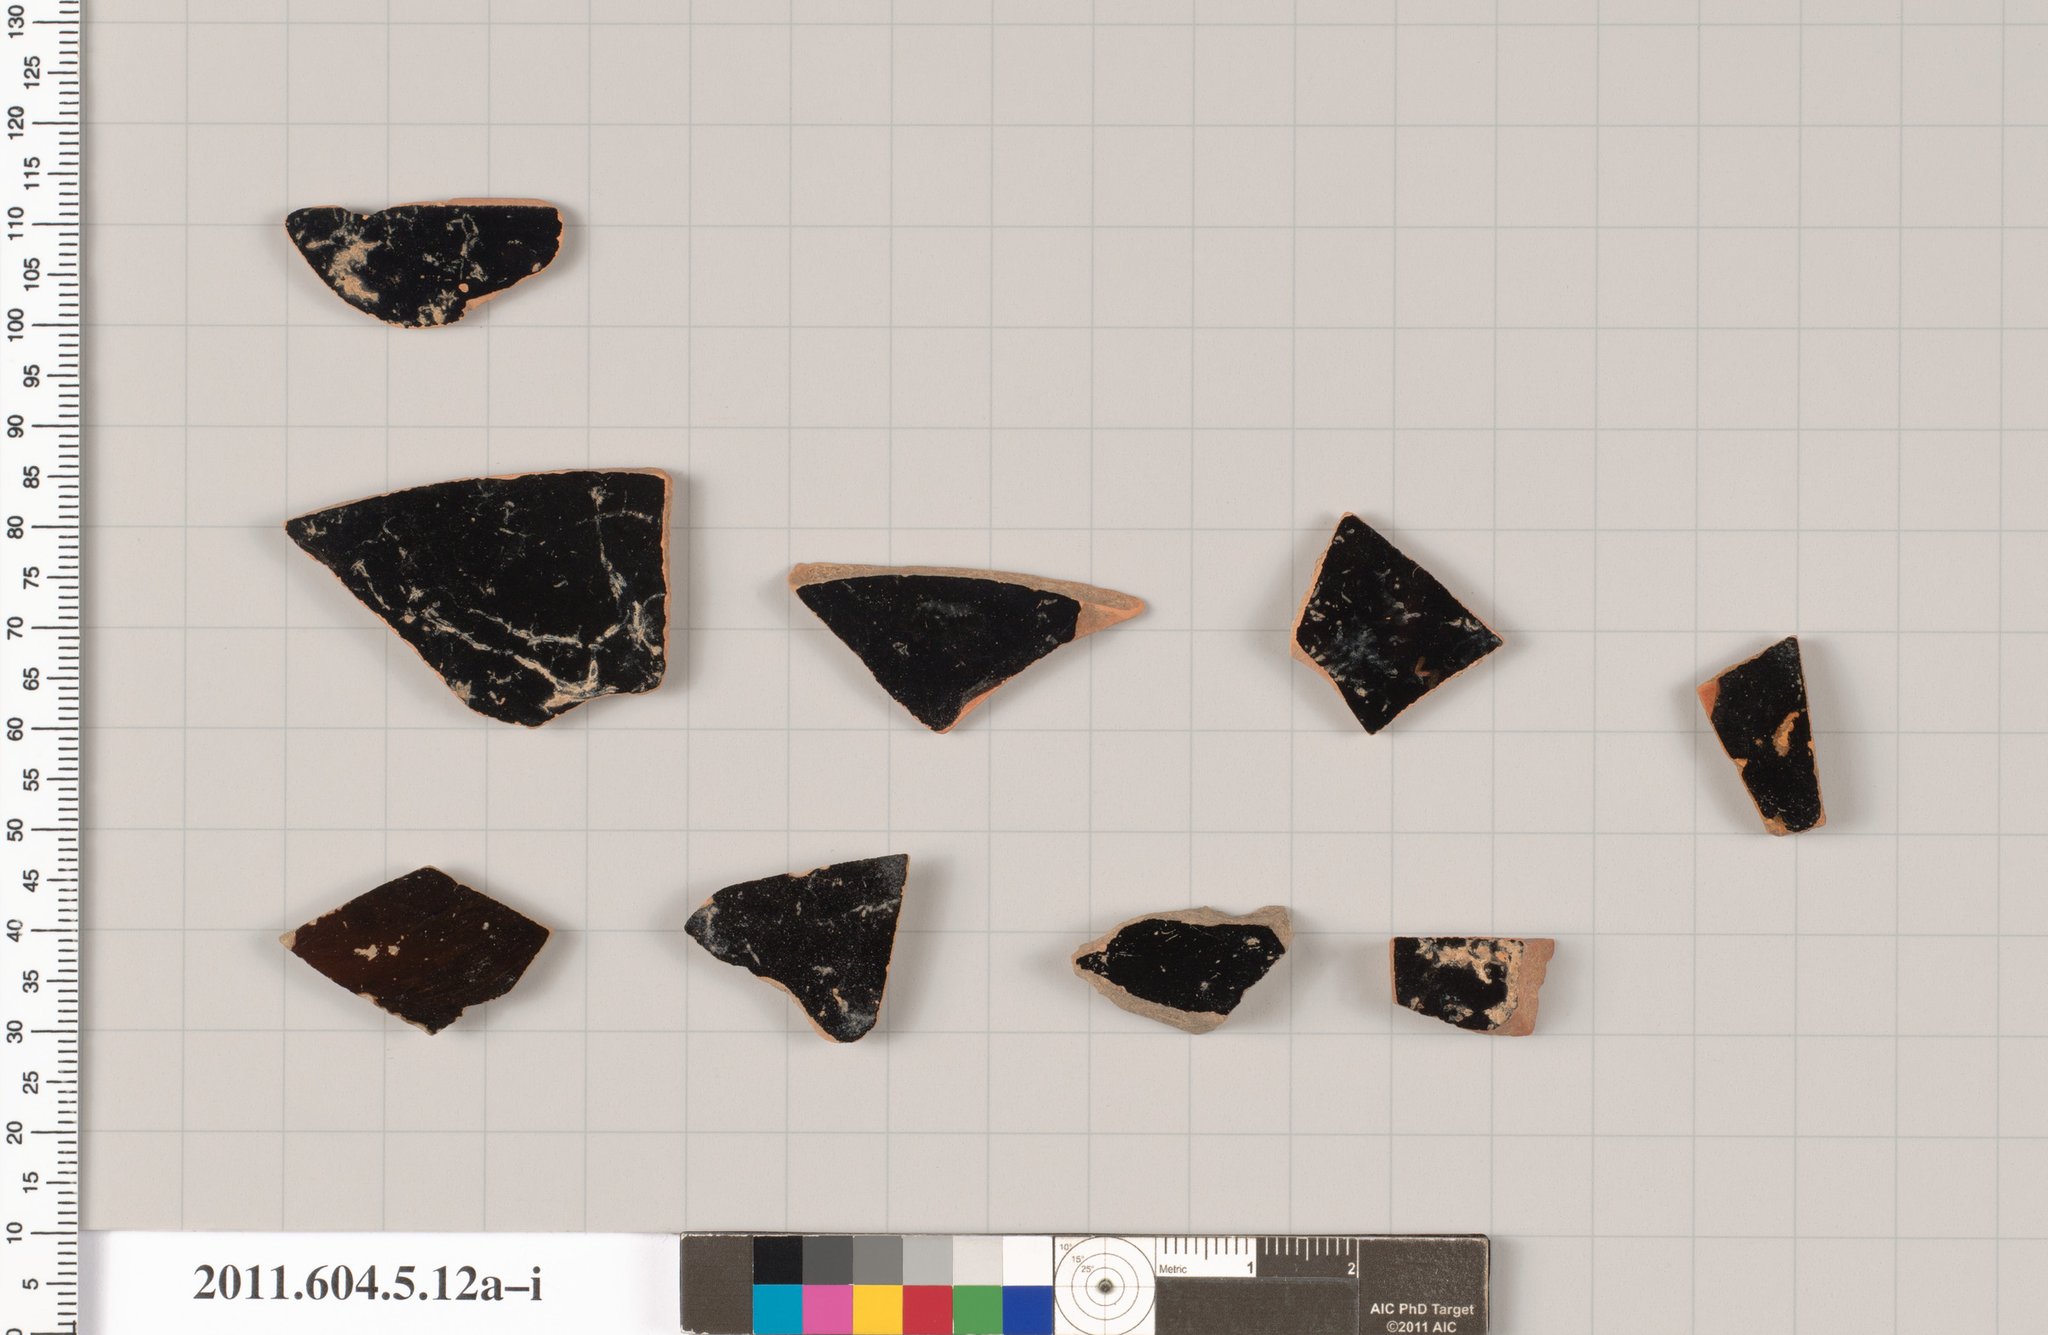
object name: kylix fragment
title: Terracotta fragments of kylikes (drinking cups)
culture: greek, attic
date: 475-451 BCE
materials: terracotta